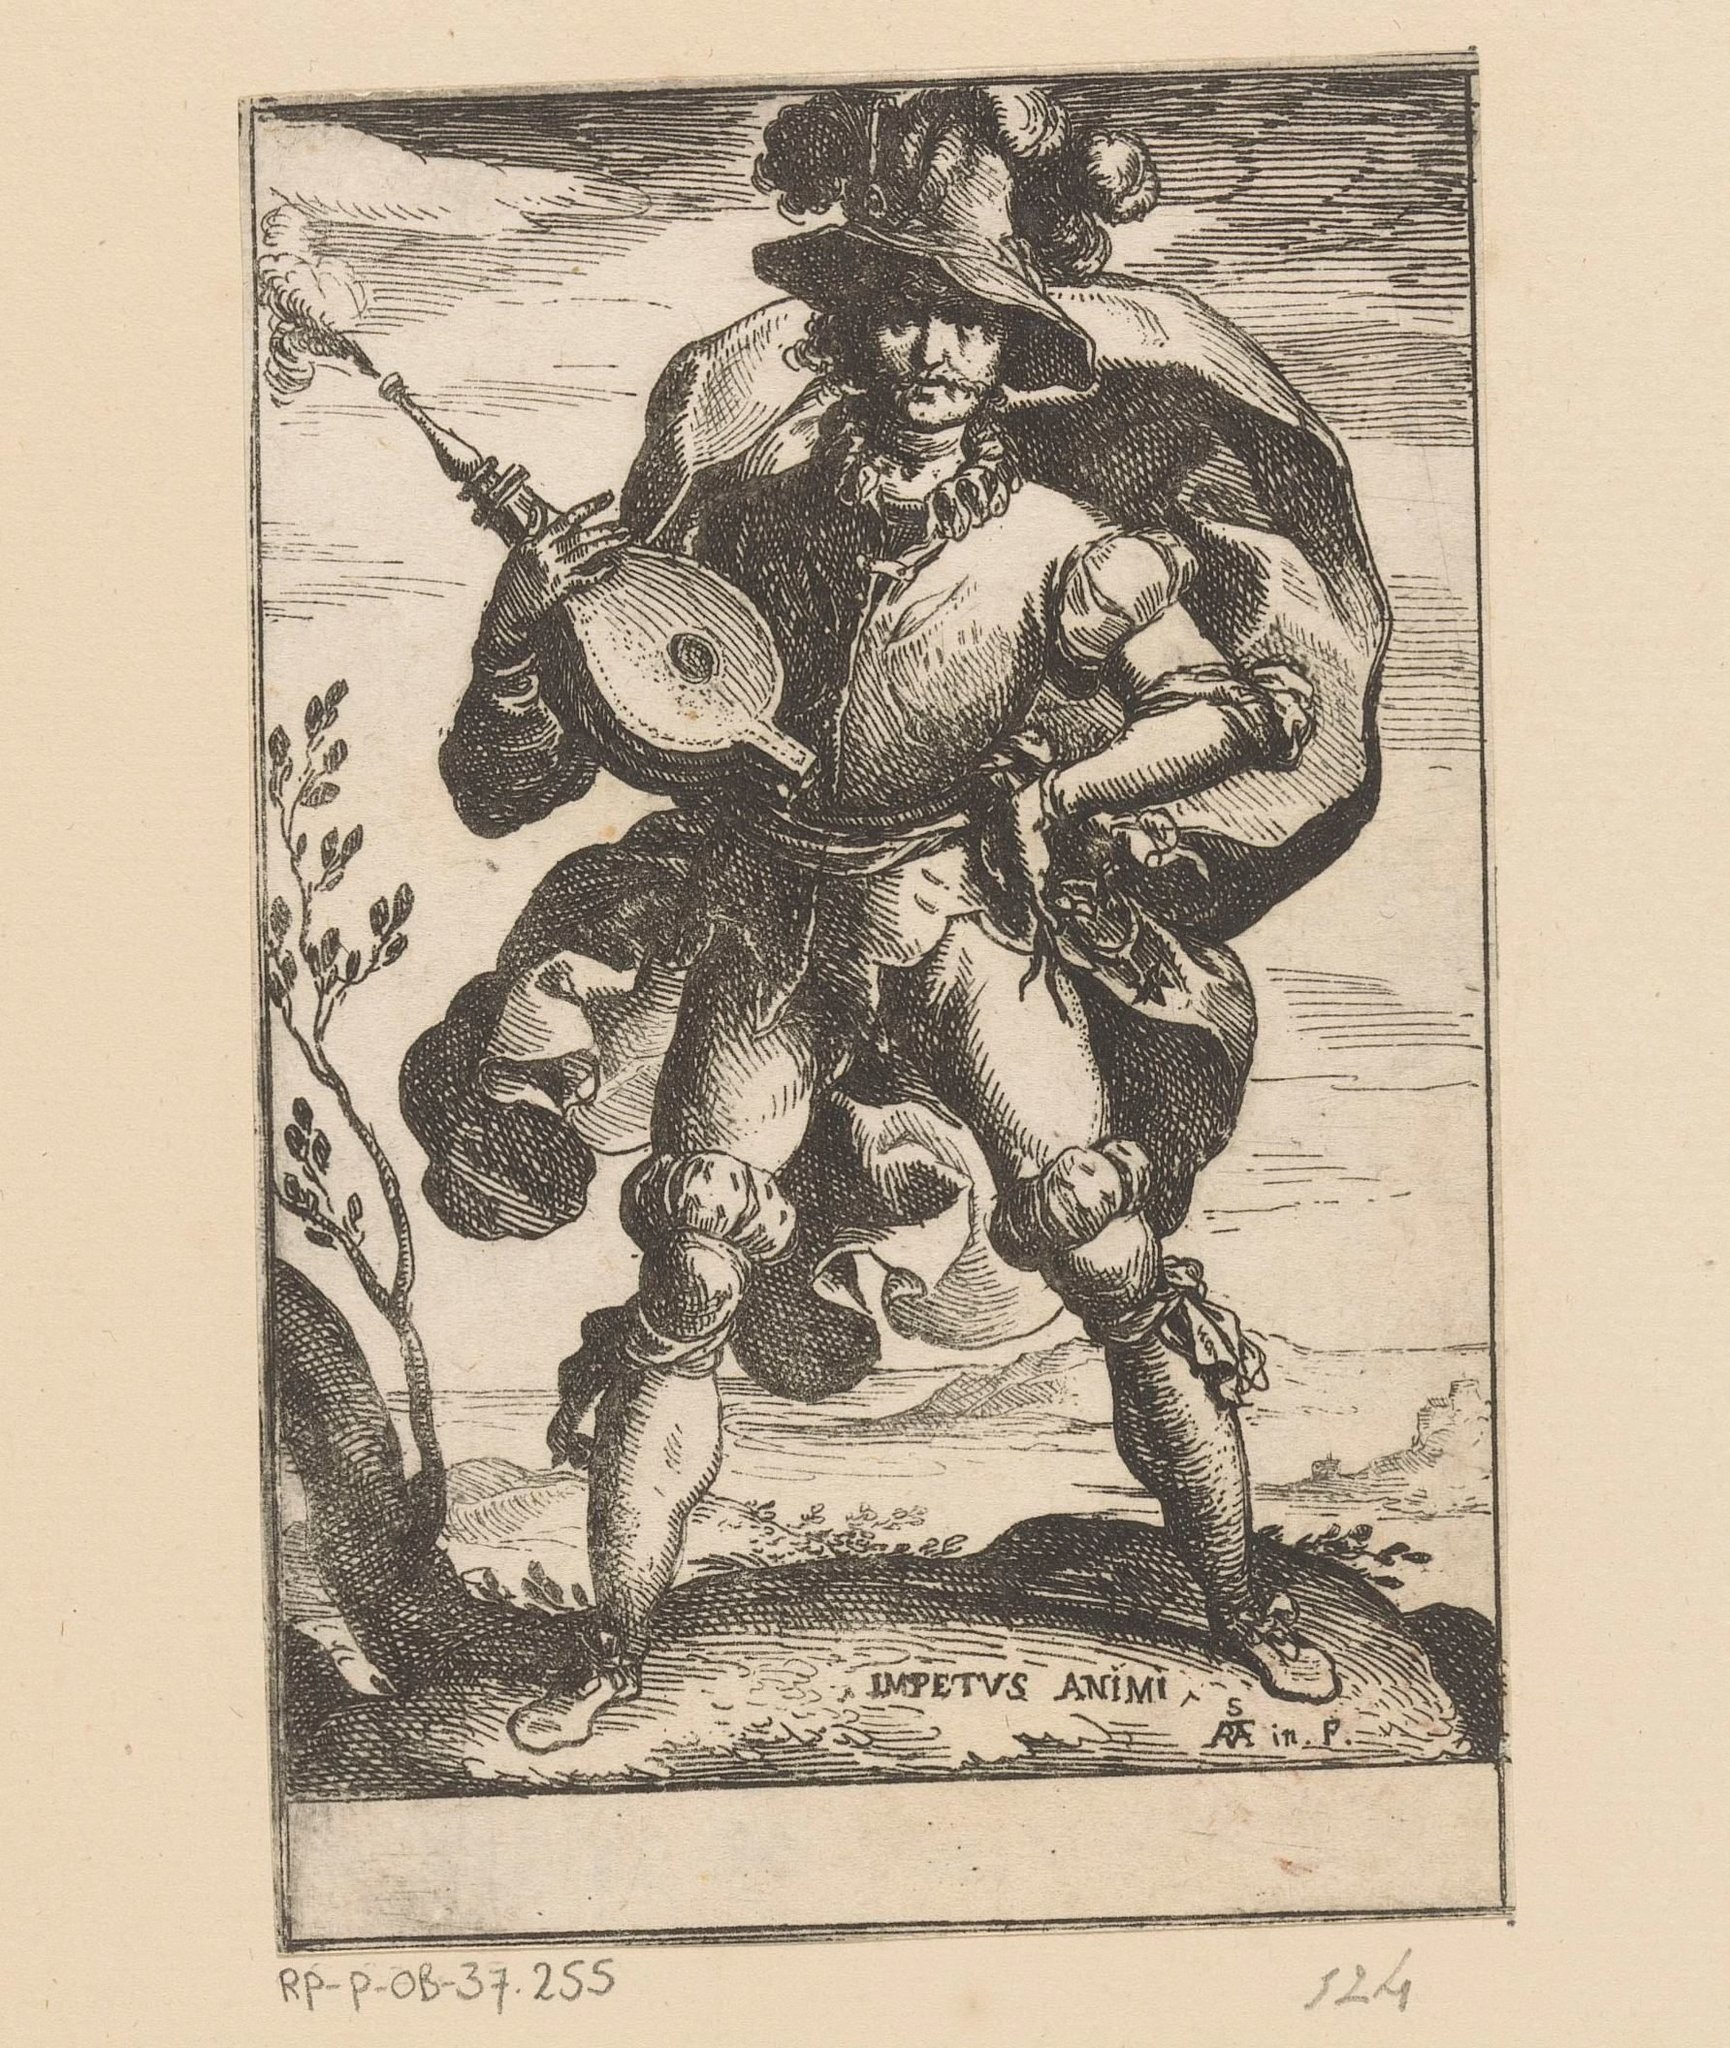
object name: print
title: Attributen van de ziel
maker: raffaello schiaminossi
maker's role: painter, print maker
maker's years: 1572-1622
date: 1605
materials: paper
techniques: etching, intaglio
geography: italy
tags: bellows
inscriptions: collector's mark: Lugt 240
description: Deze prent maakt deel uit van de serie 'Attributi dell'Anima', bestaande uit twaalf personificaties gedrukt van zes platen.